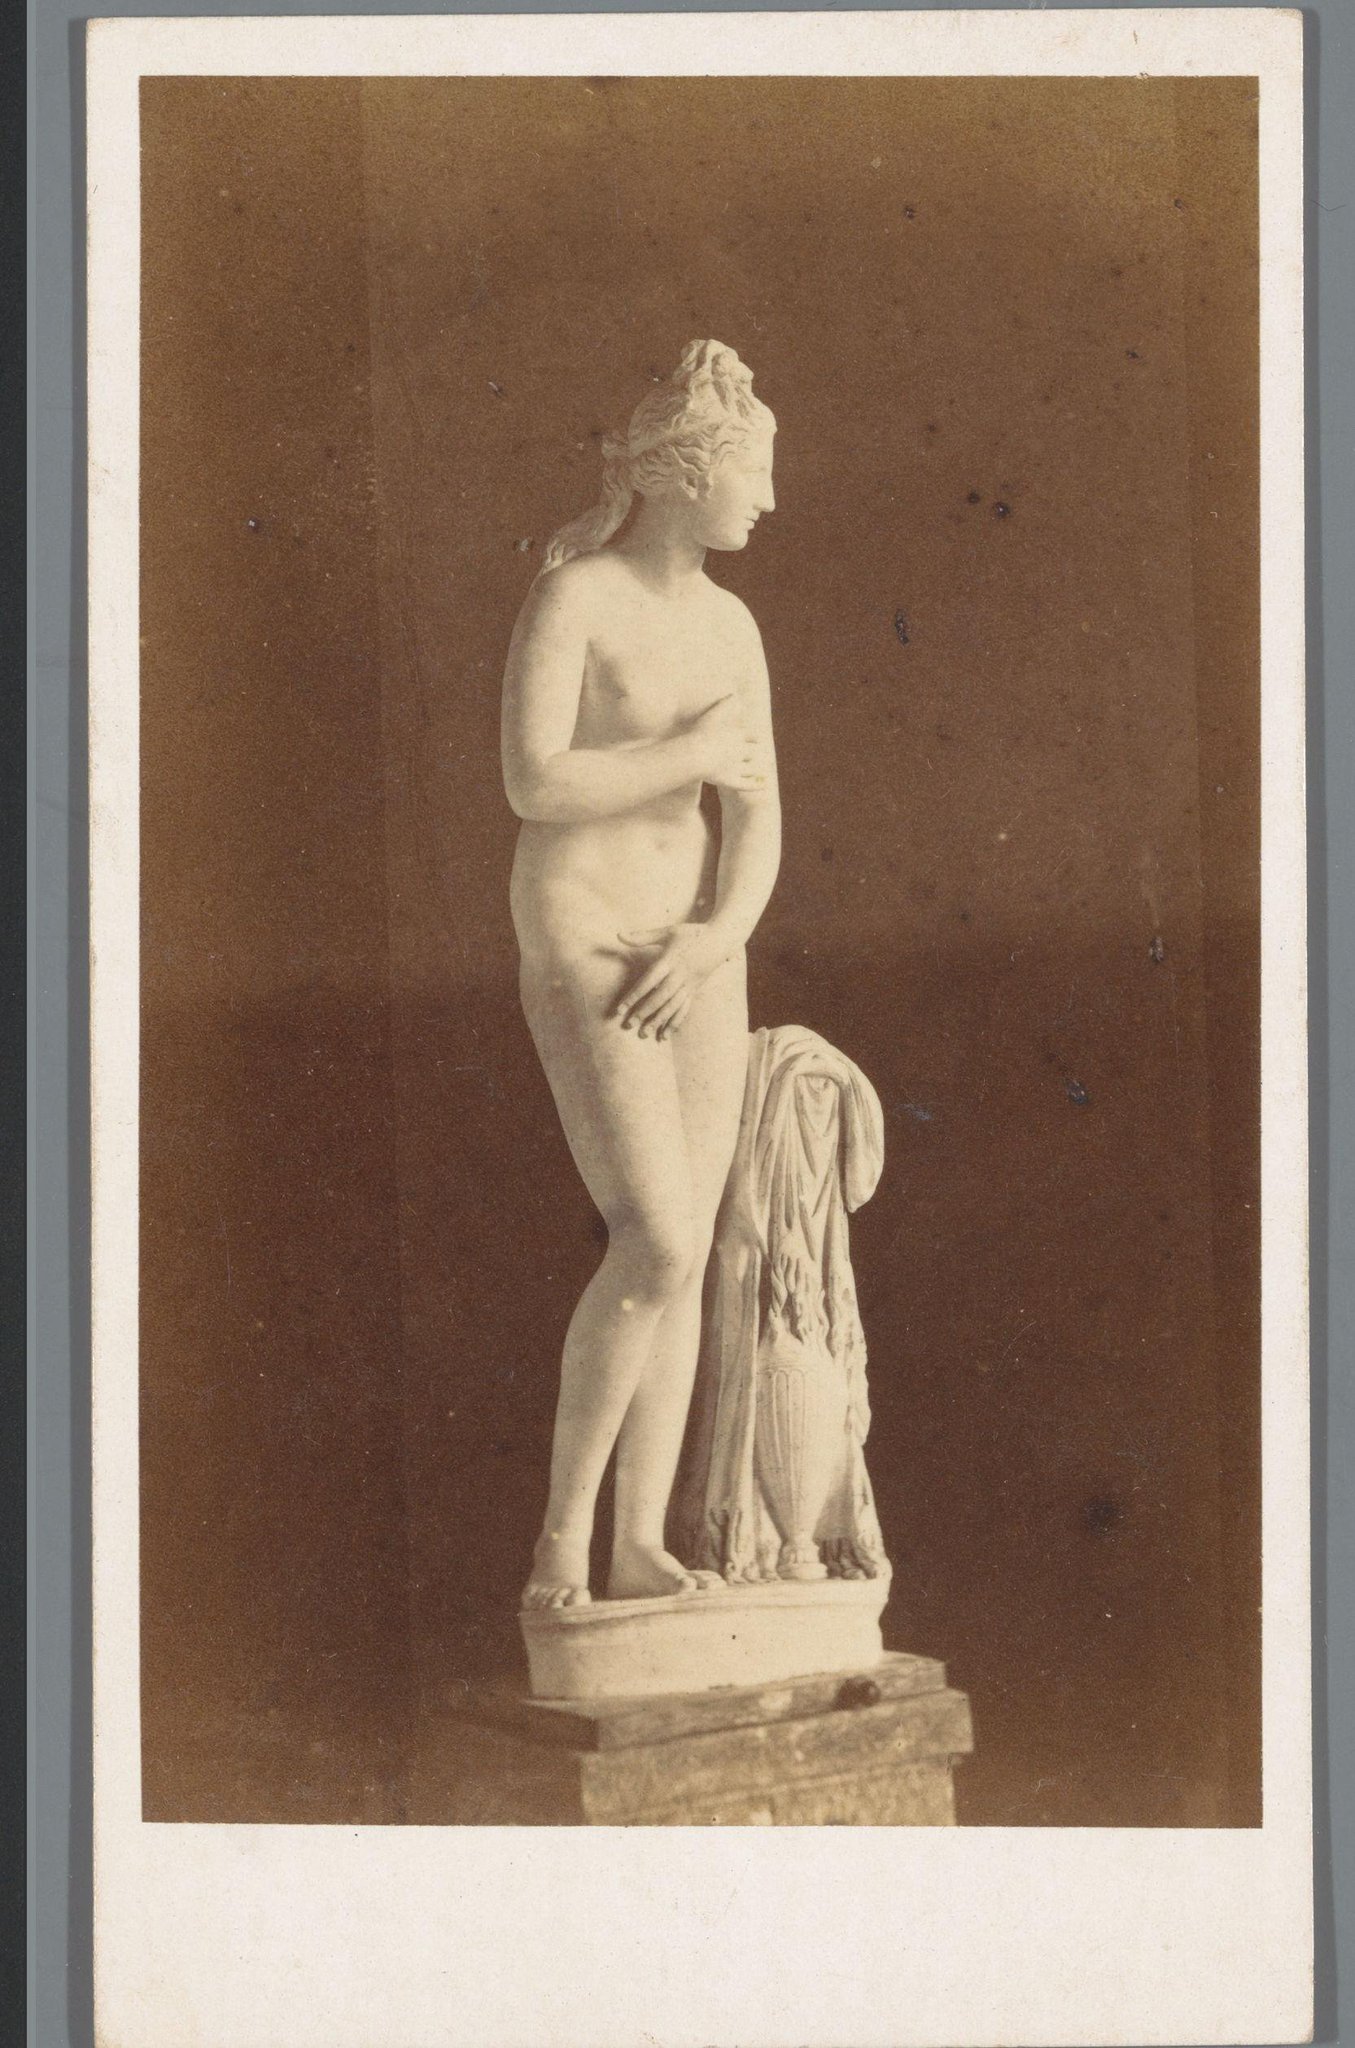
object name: photograph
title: Capitolijnse Venus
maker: Anonymous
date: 1855-1885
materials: cardboard, paper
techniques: albumen print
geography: rome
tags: toilet of venus, rome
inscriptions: inscription: ‘Libreria Spithöver/ Roma,/ 85, Piazza di Spagna’